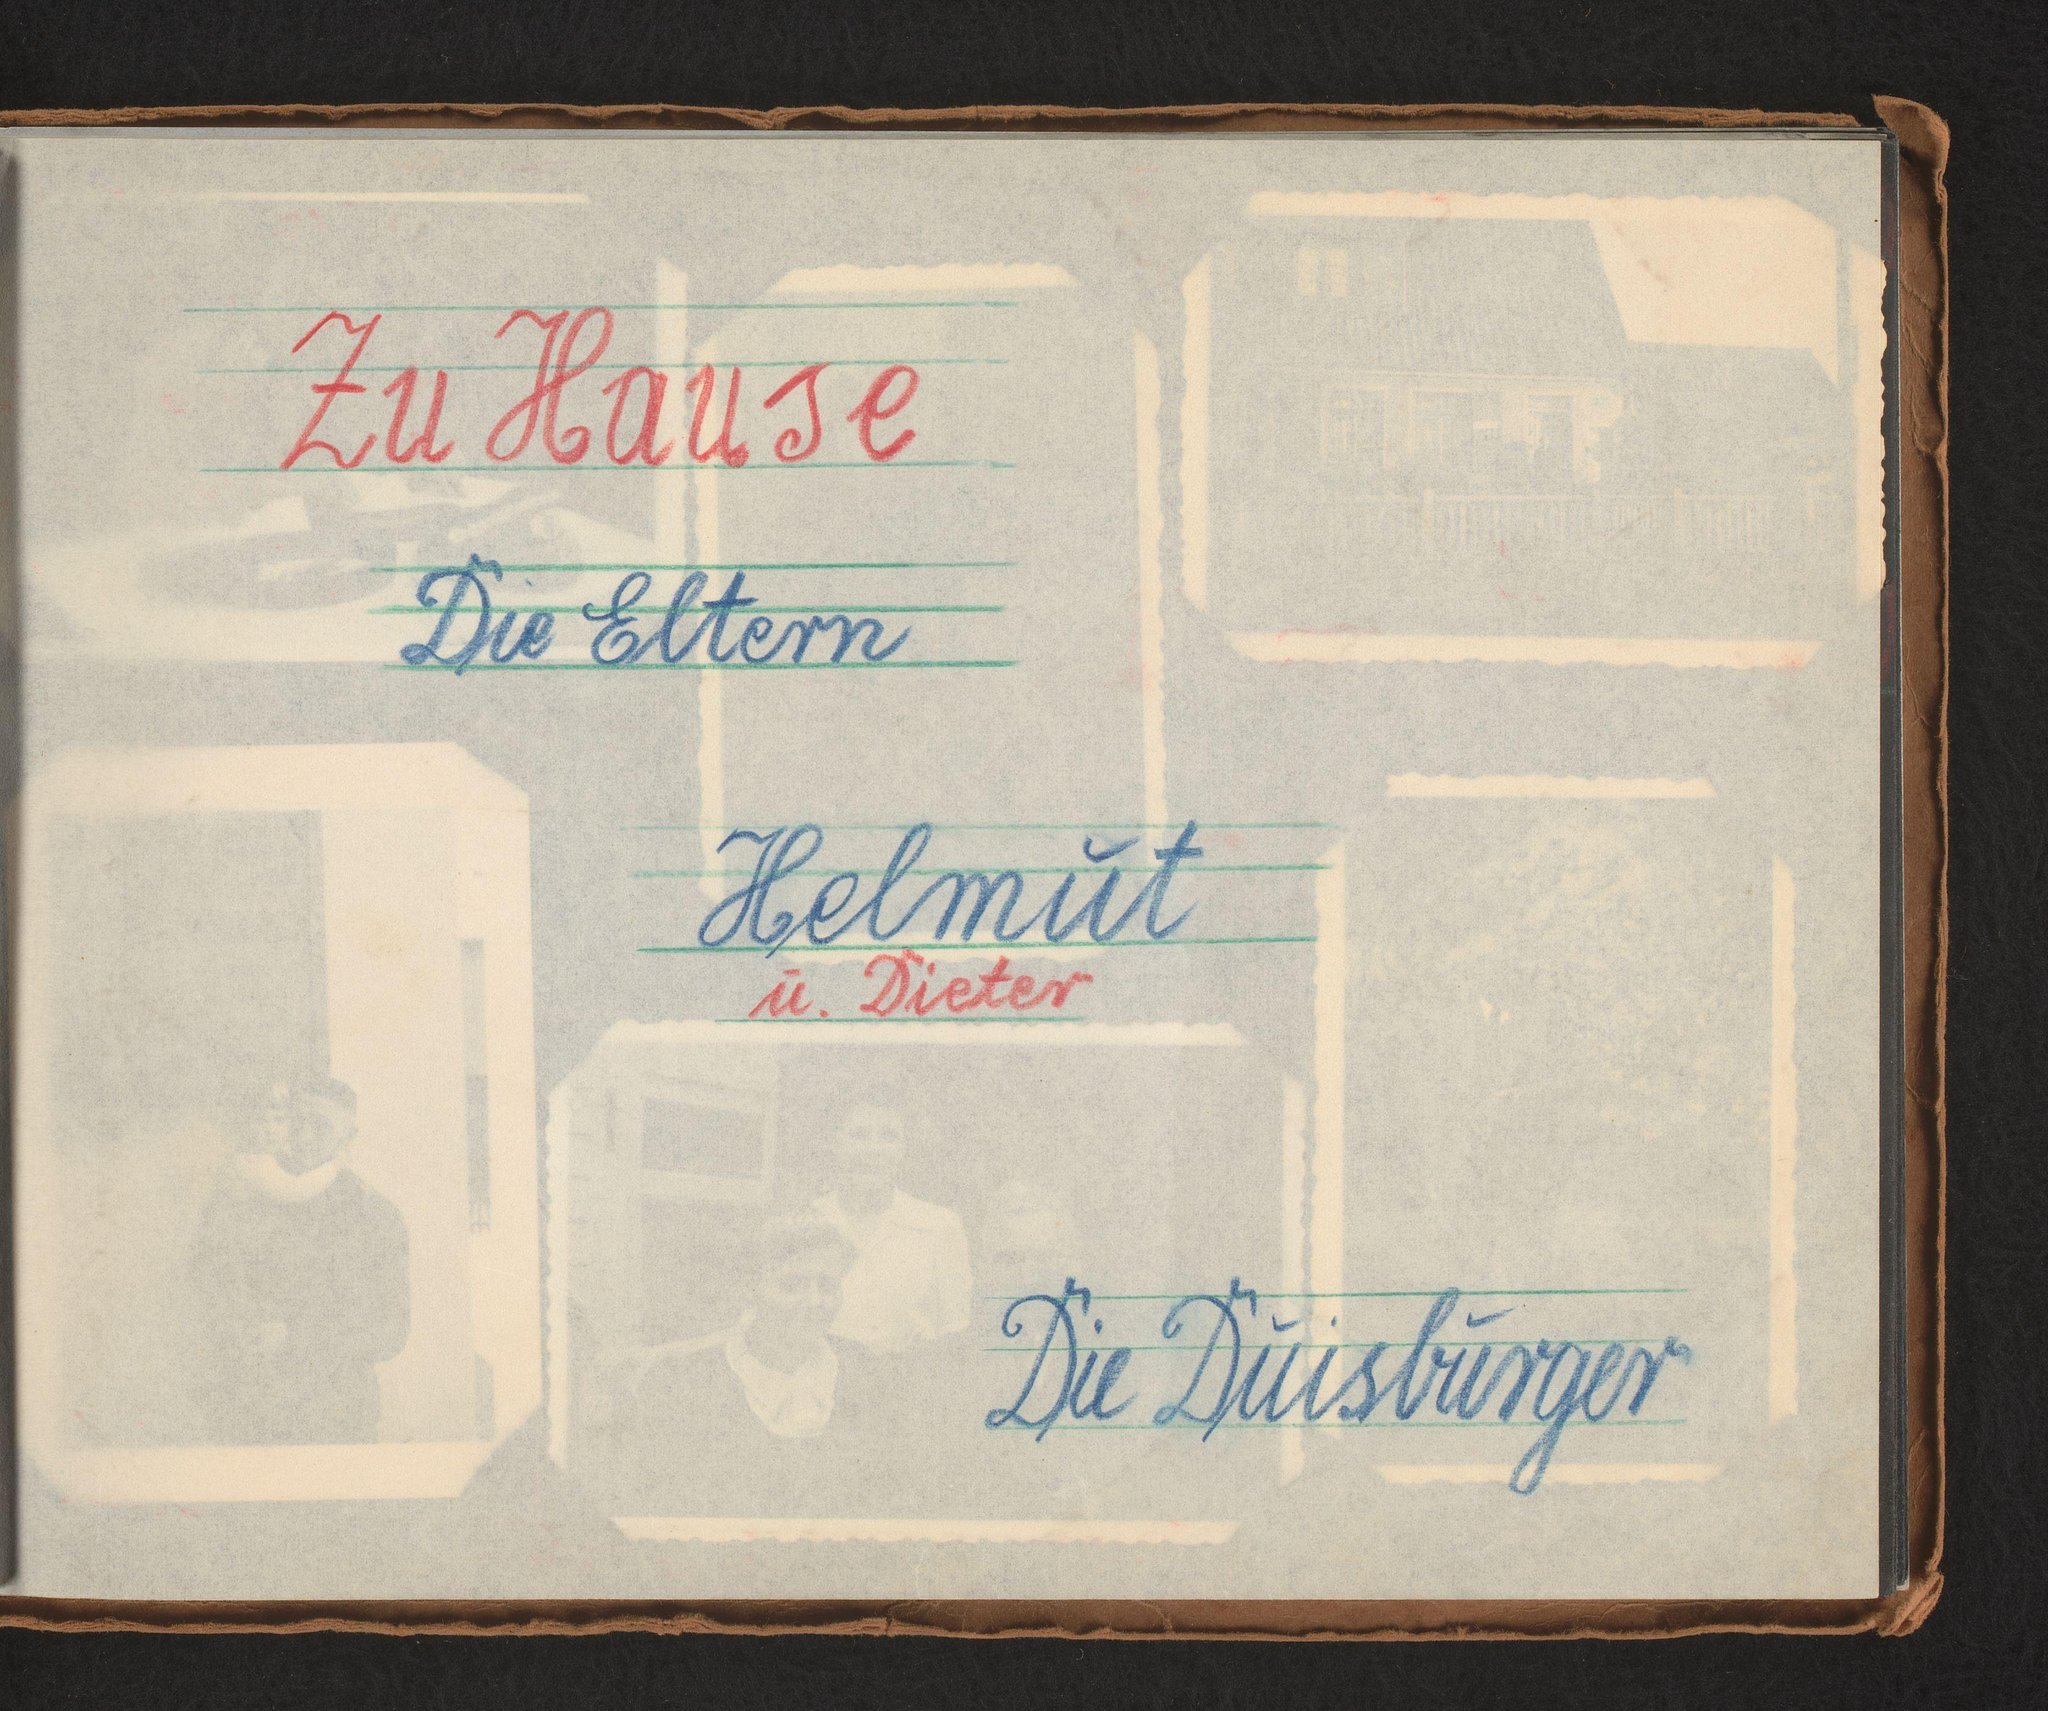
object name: album leaf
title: Duitse familie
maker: werner neufang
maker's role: militair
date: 1943-1944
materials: paper, pencil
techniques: writing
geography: germany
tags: kriegsmarine, tweede wereldoorlog, bezetting van nederland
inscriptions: inscription: ‘Zu Hause / Die Eltern / Helmut u. Dieter / Die Duisburger’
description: Blad met tekst over de familie van Werner in Duitsland. Tussenblad tussen bladzijde 8 en 9. Onderdeel van een fotoalbum over de Duitse Werner Neufang van de Kriegsmarine en de Nederlandse Thea Driesen.